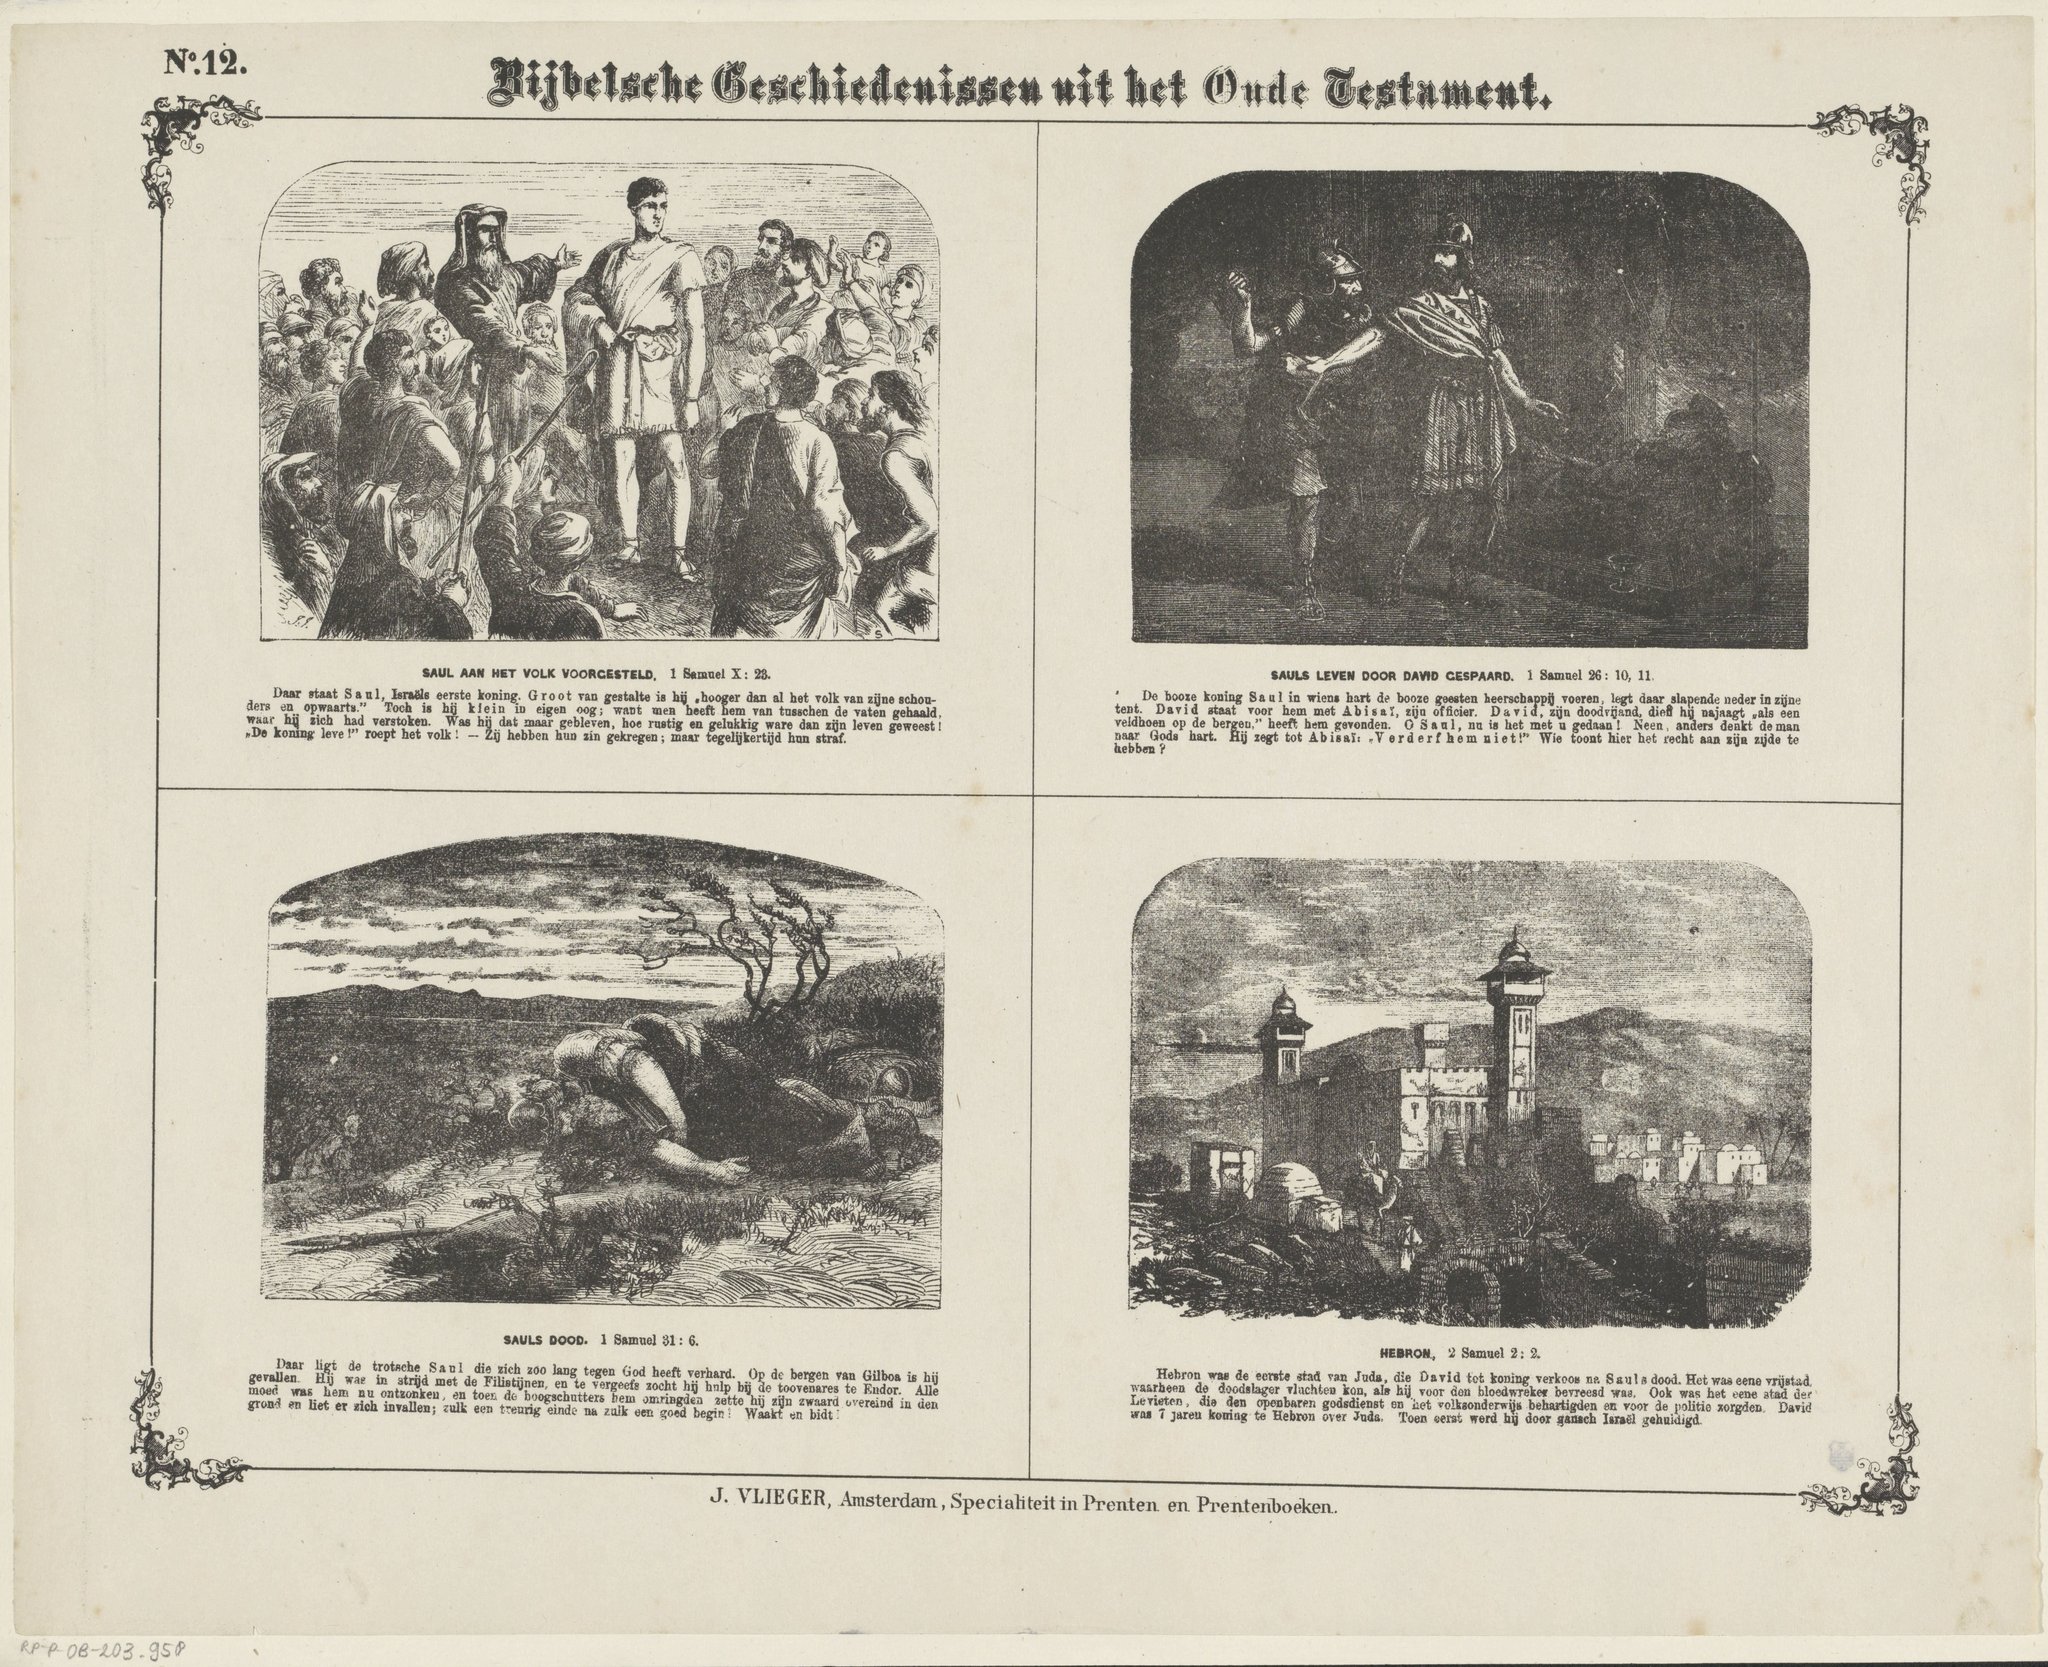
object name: print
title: Bijbelsche geschiedenissen uit het Oude Testament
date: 1871-1908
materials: paper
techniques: letterpress printing, engraving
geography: amsterdam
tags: saul and david in the same cave; saul relieving himself, story of saul, old testament, saul's death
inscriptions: collector's mark: Lugt 2760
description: Blad met 4 voorstellingen van verhalen en plaatsen uit het Oude Testament. Saul wordt aan het volk voorgesteld, David spaart Sauls leven, de dood van Saul en Hebron. Onder elke afbeelding de bijbehorende Bijbeltekst. Genummerd linksboven: No. 12.